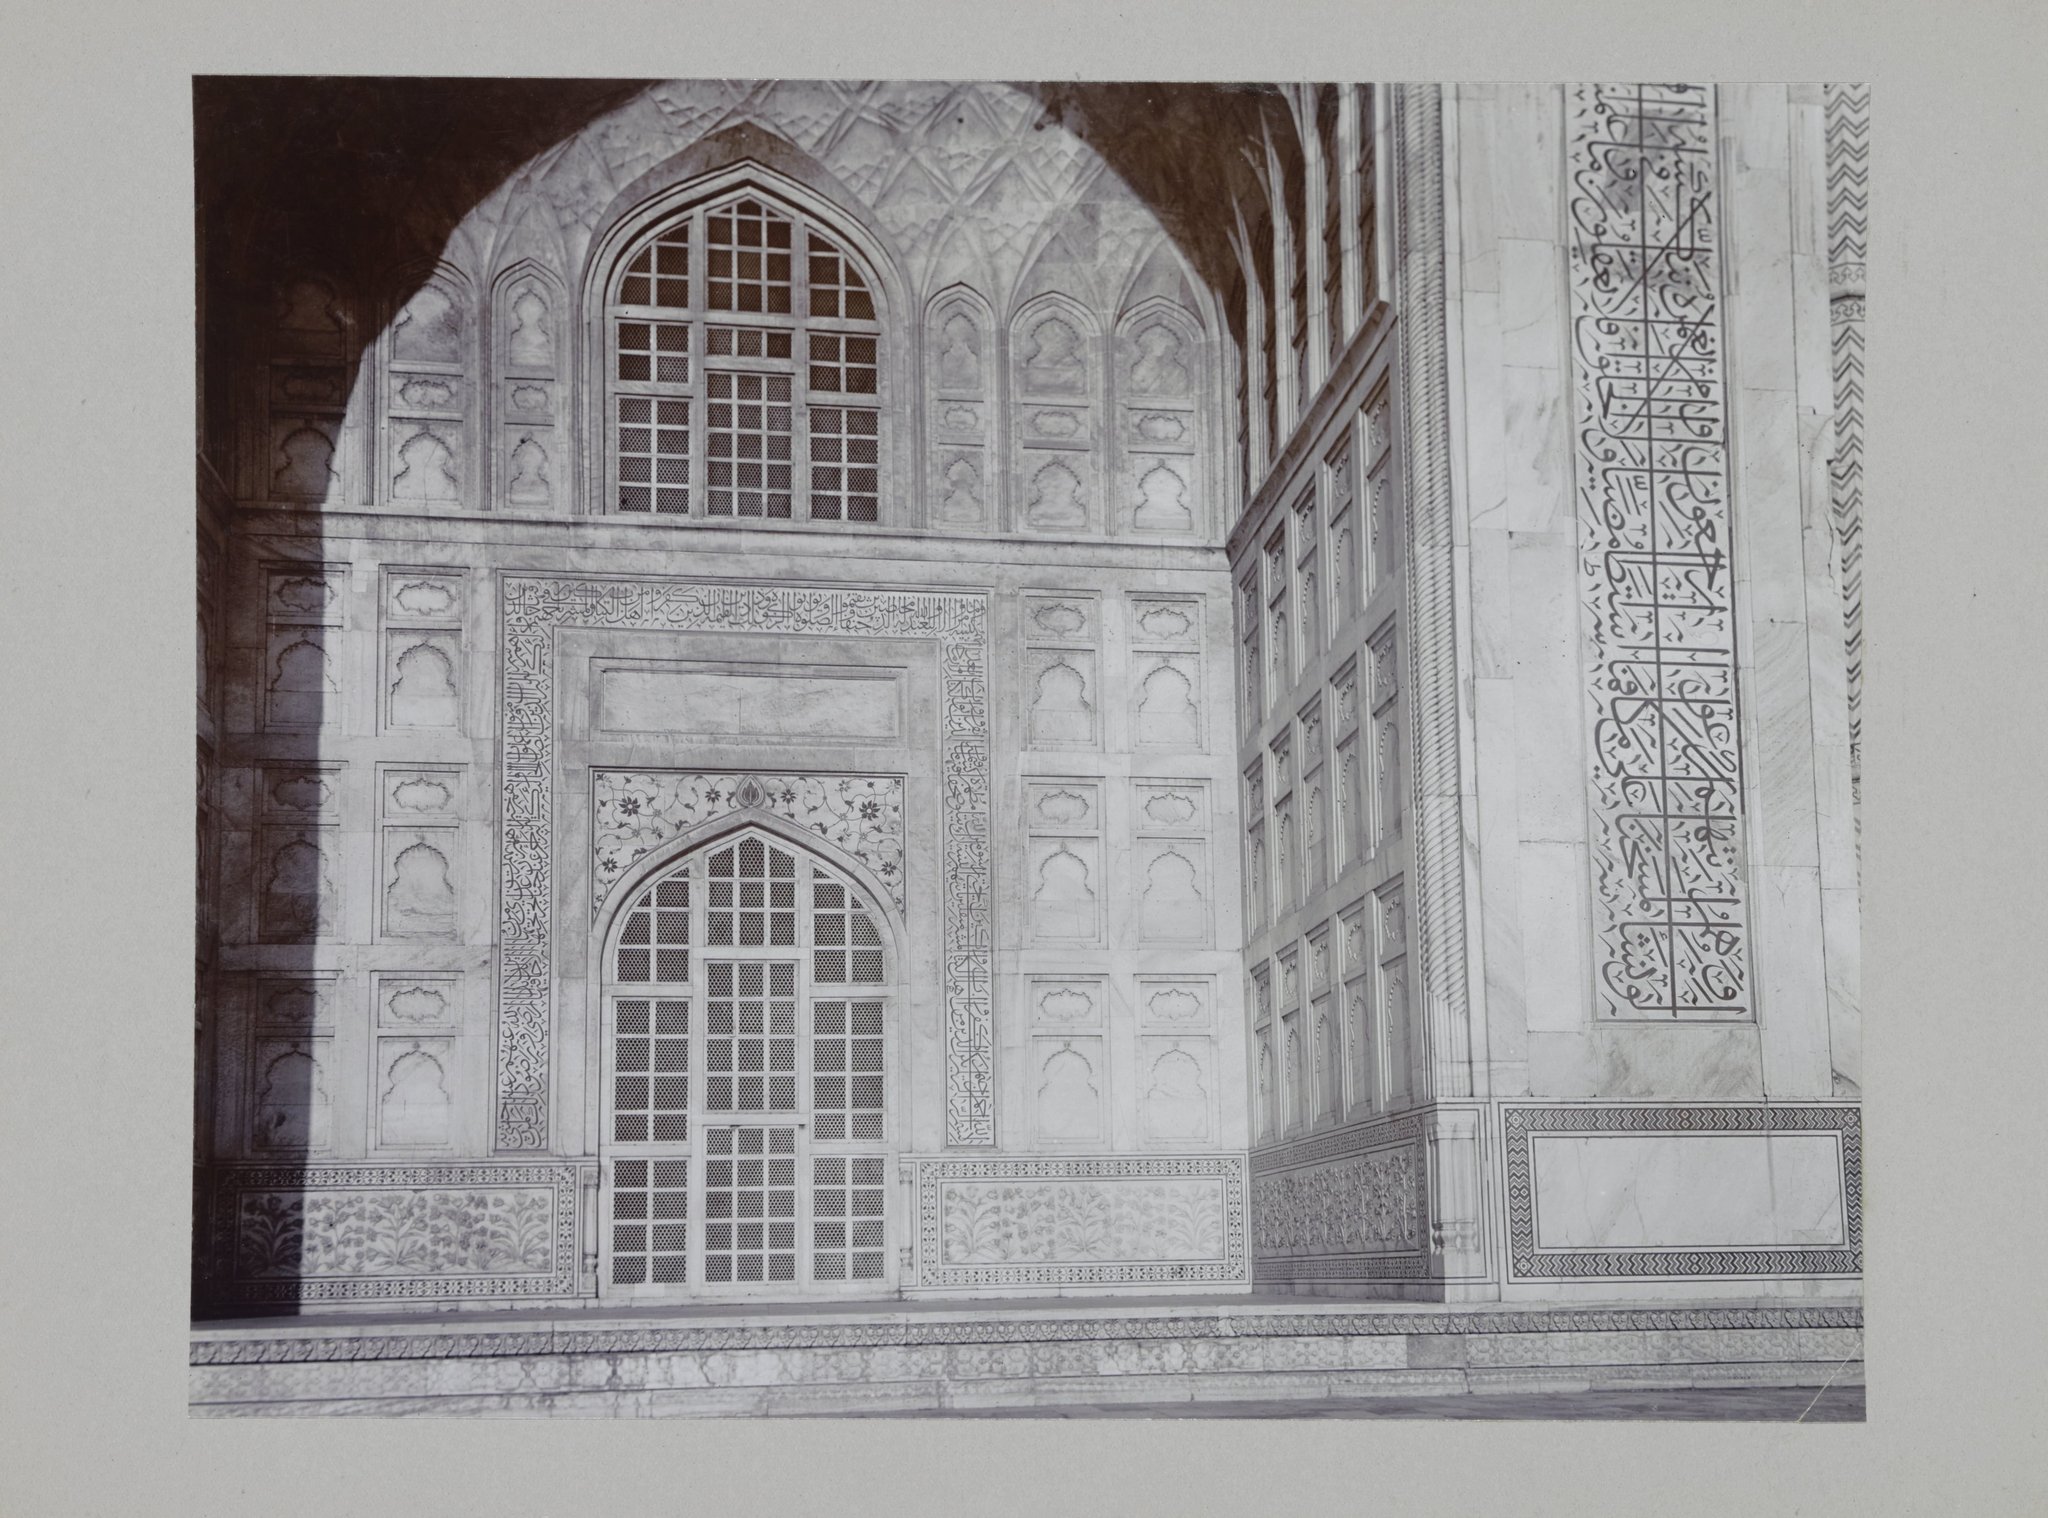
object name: photograph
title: Door of the Taj Mahal, Agra, Uttar Pradesh, India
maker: Anonymous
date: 1895-1915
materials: cardboard, paper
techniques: gelatin silver print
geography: agra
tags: agra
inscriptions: annotation: ‘56. Deur v/d Taj. mahal’